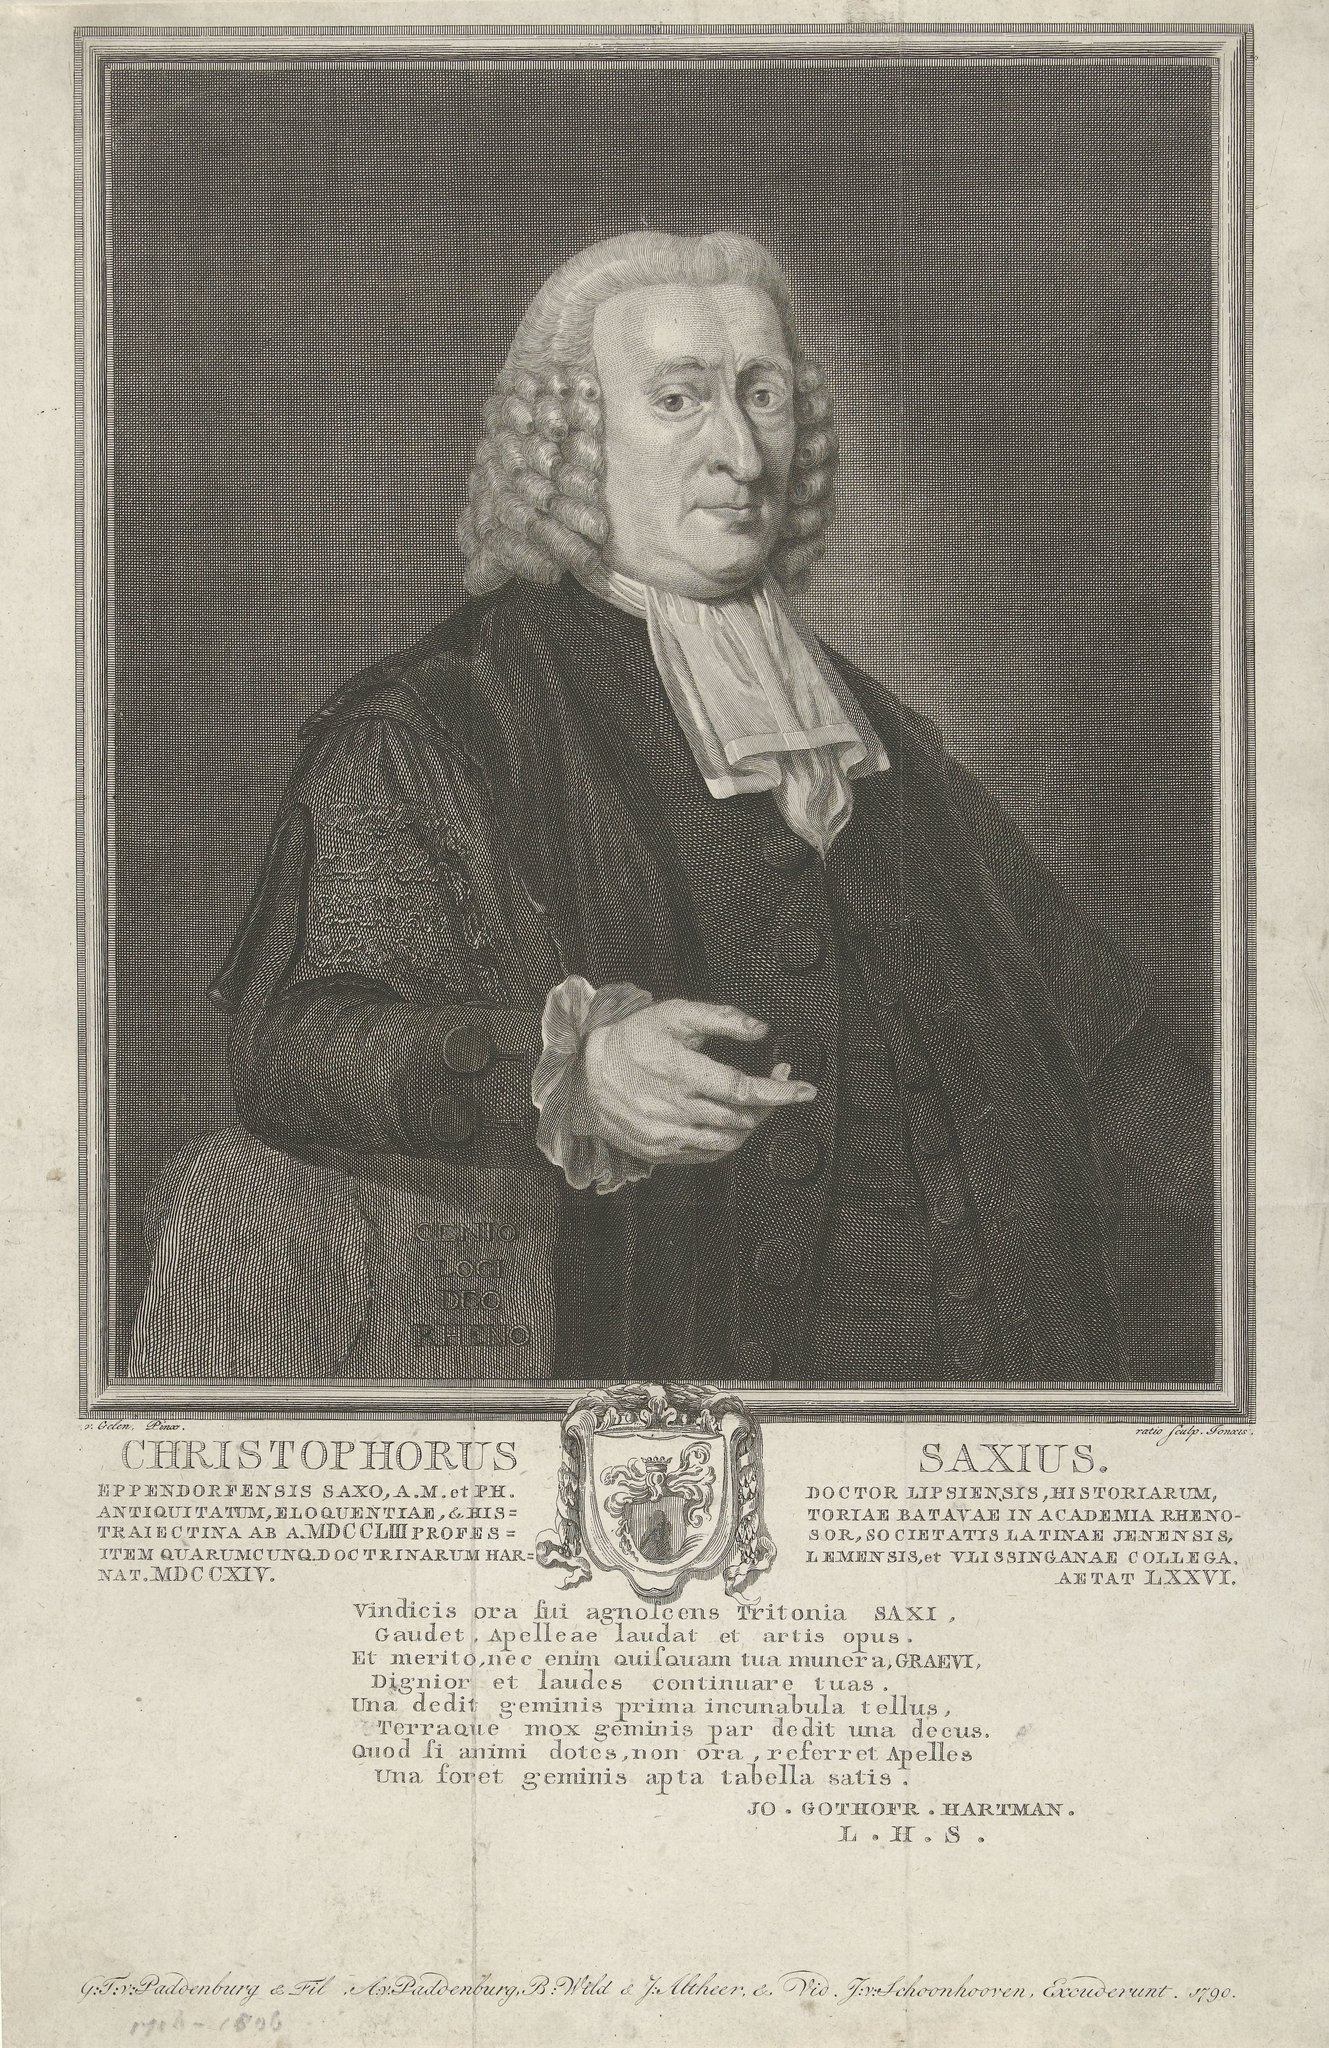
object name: print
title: Portret van Christophorus Saxius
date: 1790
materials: paper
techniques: engraving, etching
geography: utrecht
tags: hoogleraar, christophorus saxius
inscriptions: collector's mark: Lugt 2228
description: Portret van de hoogleraar Christophorus Saxius, ten halven lijve. Hij draagt een toga en leunt met zijn rechterarm op een steen met een opschrift in het Latijn. In de marge het wapenschild van de geportretteerde en een tienregelig onderschrift, in twee kolommen, in het Latijn. En een achtregelig gedicht in het Latijn.